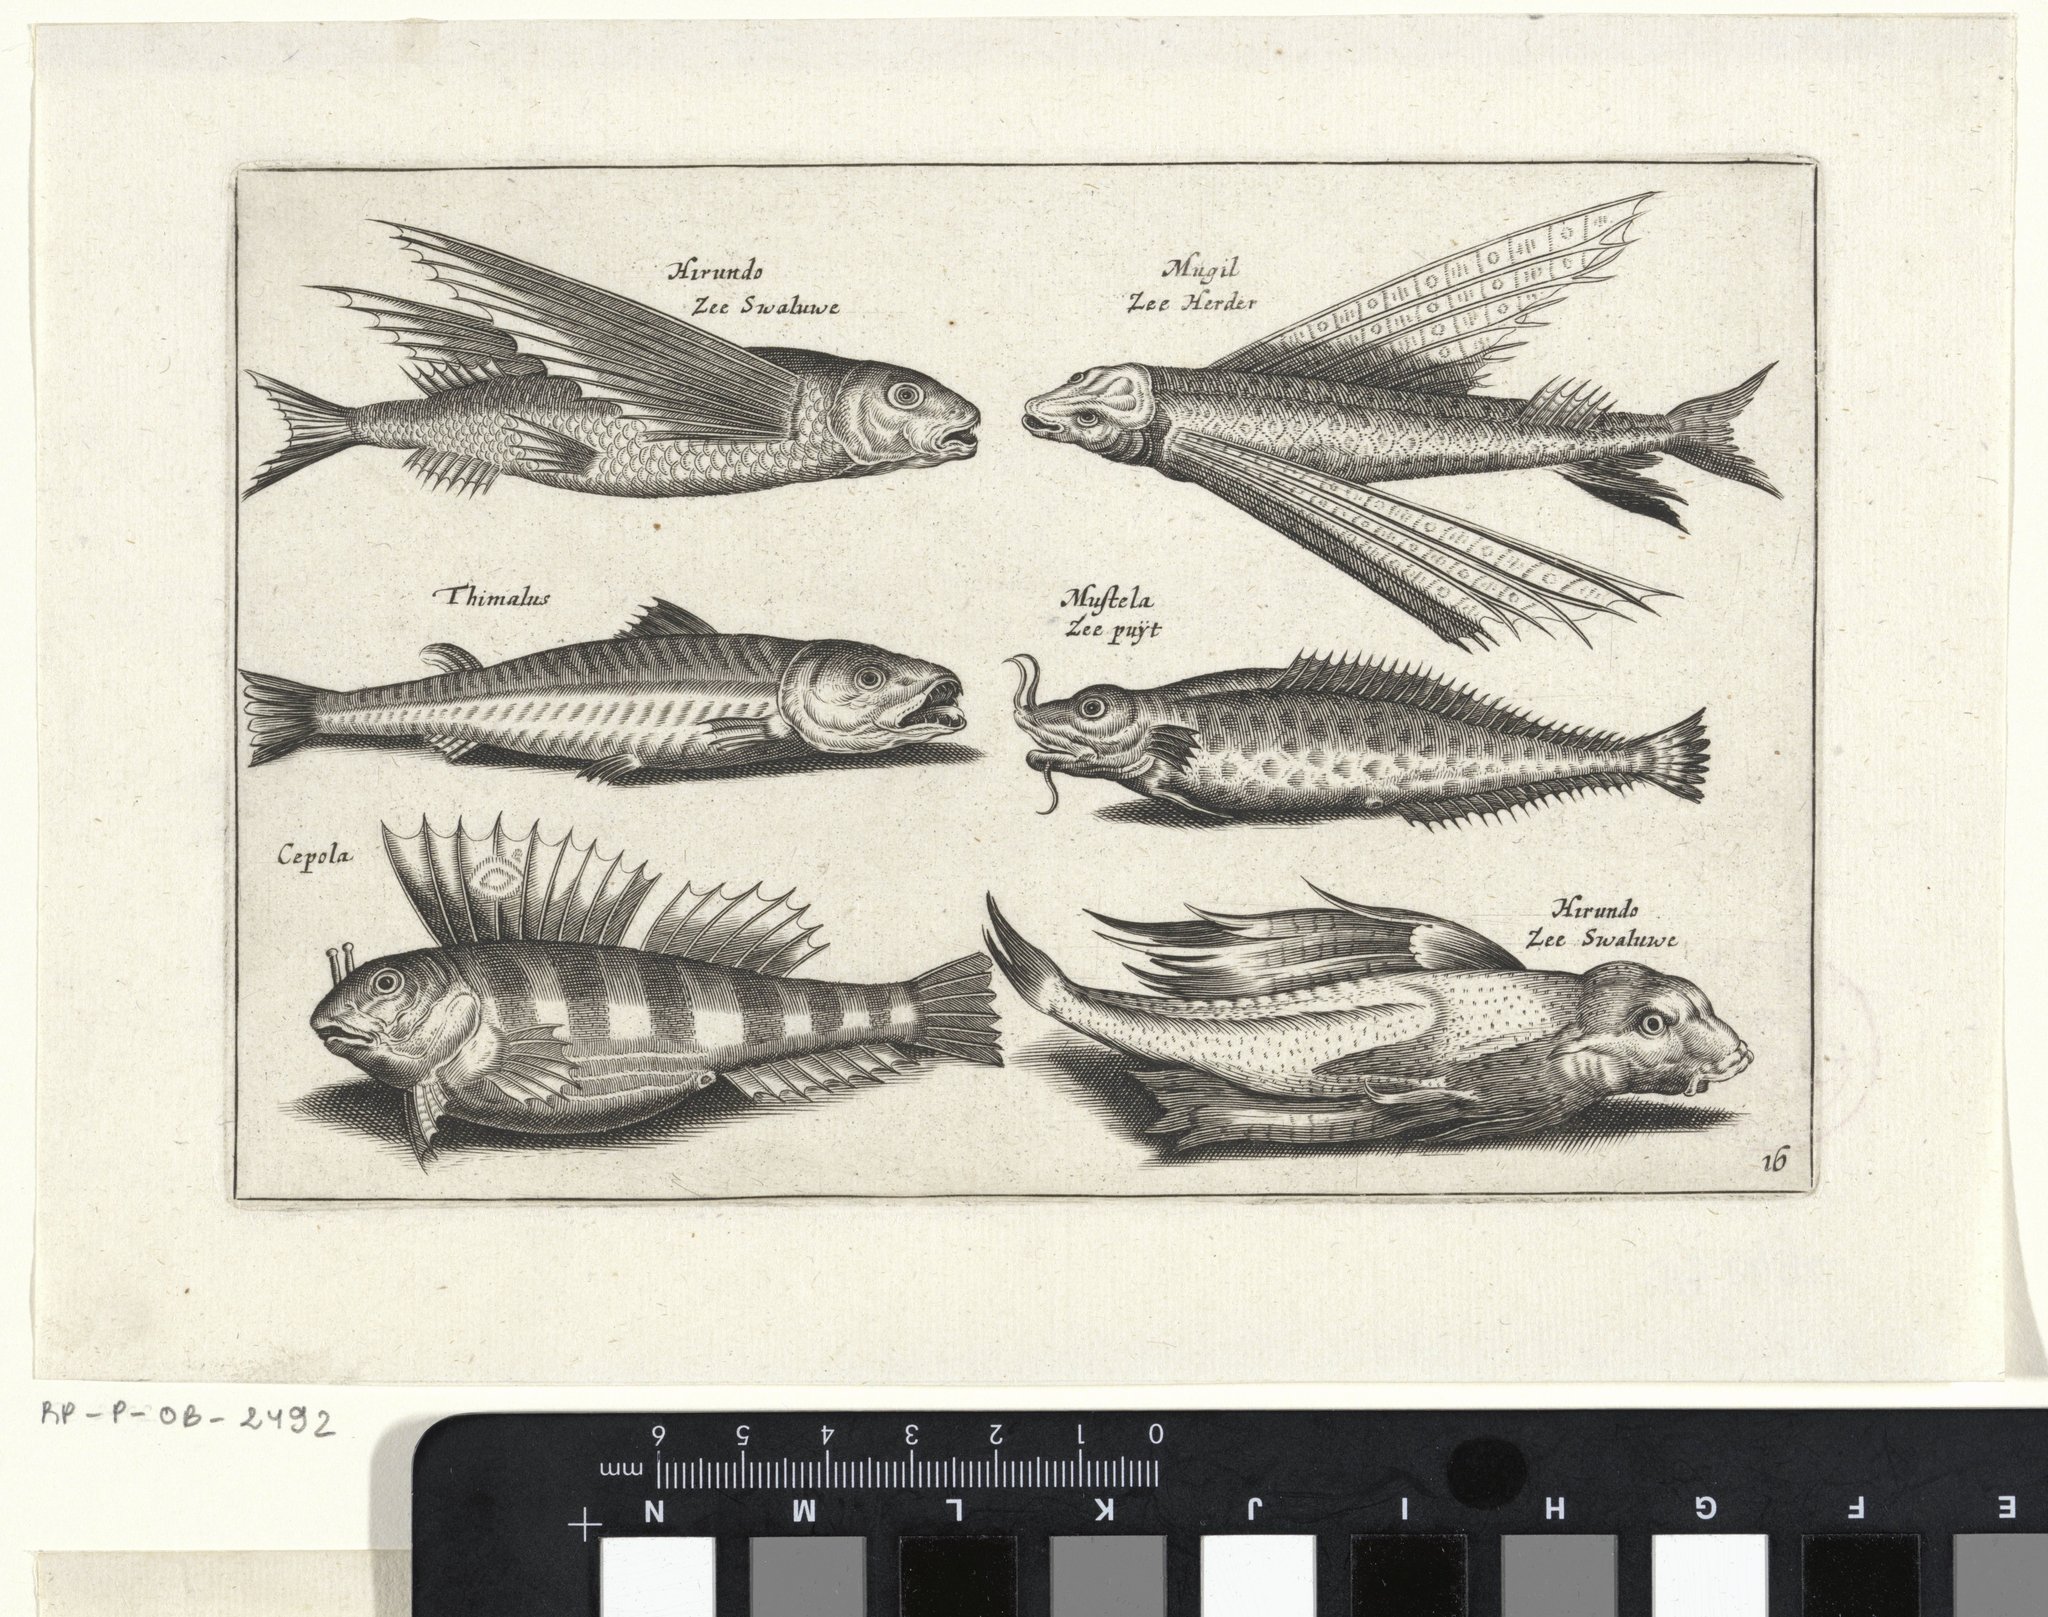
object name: print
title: Zes vissen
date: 1634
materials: paper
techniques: engraving, etching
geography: amsterdam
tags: fishes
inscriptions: collector's mark: Lugt 240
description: Zes verschillende vissen. Elke vis is voorzien van zijn naam. De prent maakt deel uit van een serie met vissen als onderwerp.